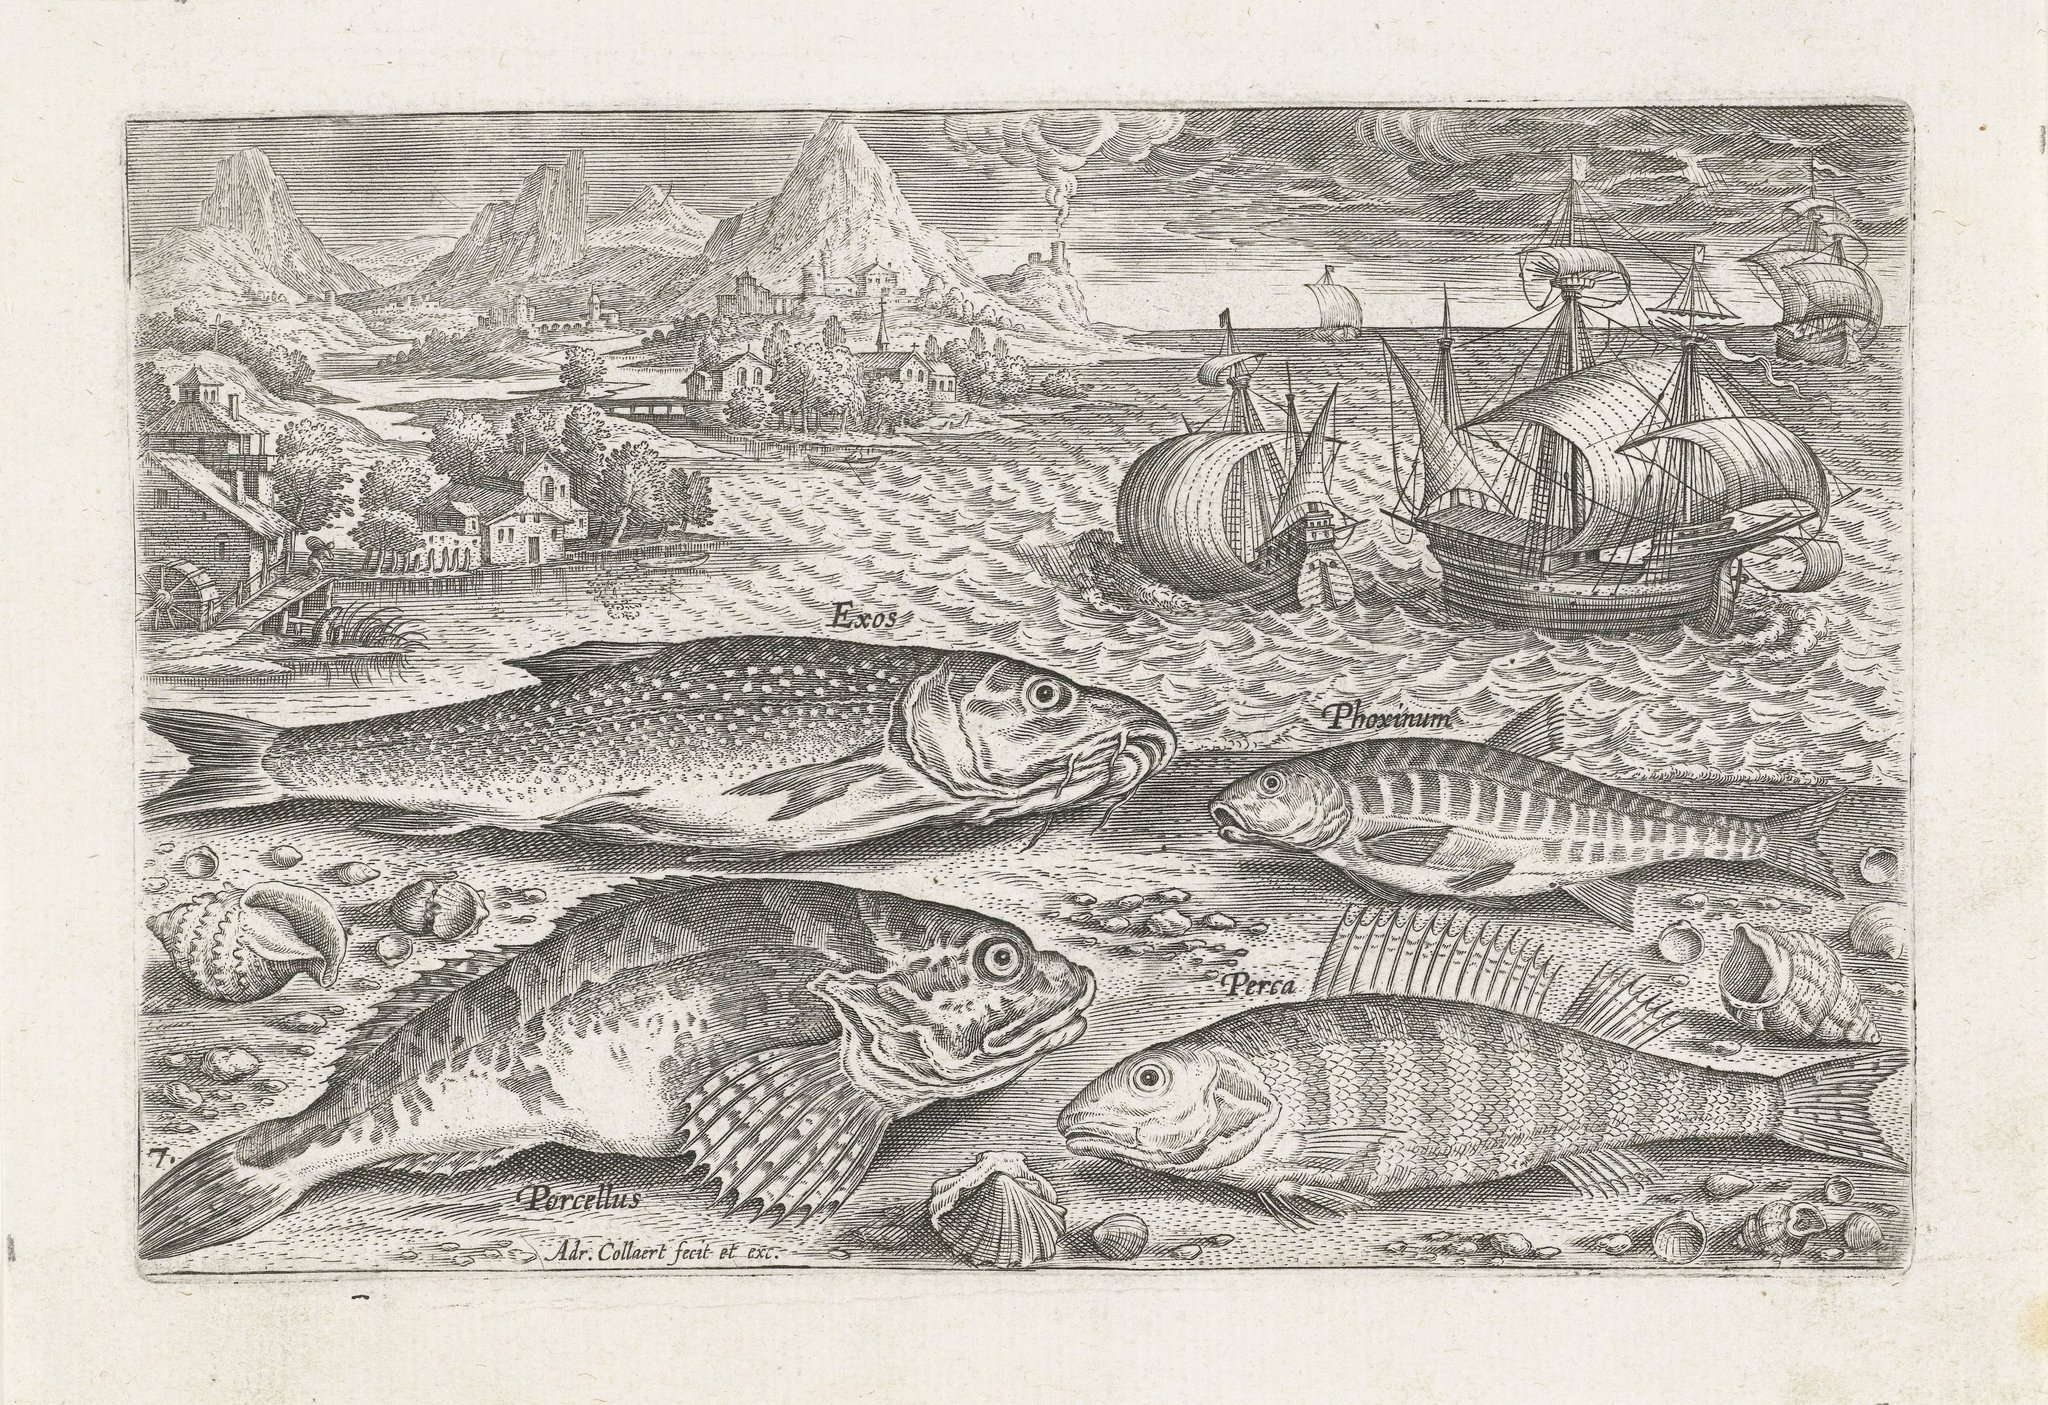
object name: print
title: Vissen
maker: adriaen collaert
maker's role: draughtsman, print maker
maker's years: 1560-1618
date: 1598-1618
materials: paper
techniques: engraving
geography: antwerp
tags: sea (seascape), bony fishes: carp, bony fishes: sea-perch, bony fishes: minnow, bony fishes: catfish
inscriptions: collector's mark: Lugt 2228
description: Een karper, een elrits, een meerval en een baars liggen samen met wat schelpen aangespoeld op het strand. Op de achtergrond de zee met enkele schepen. De prent maakt deel uit van een serie met vissen als onderwerp.